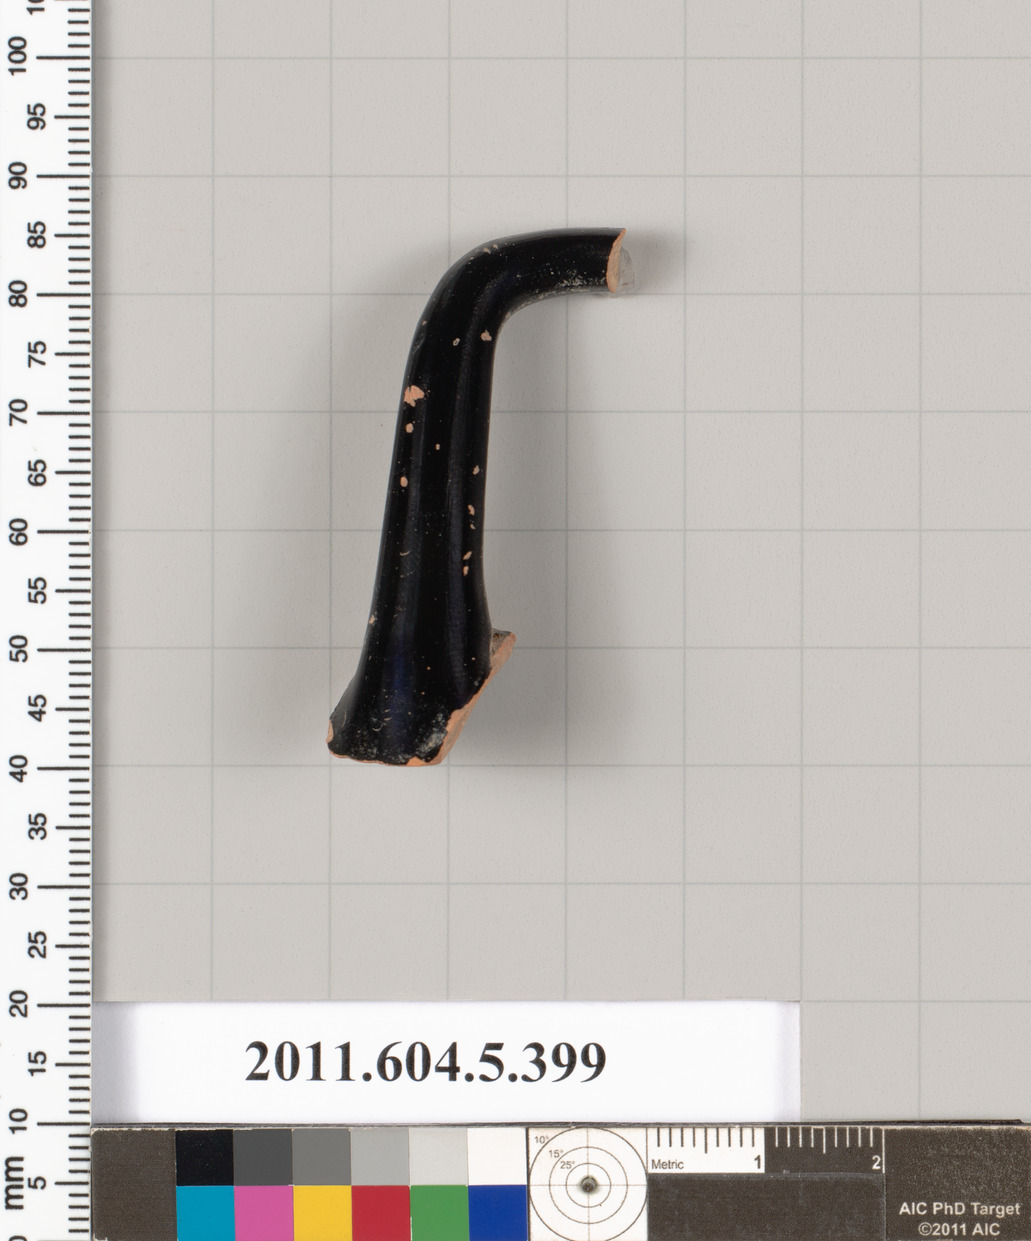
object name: kylix fragment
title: Terracotta fragment of a kylix (drinking cup)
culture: greek, attic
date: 600-401 BCE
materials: terracotta